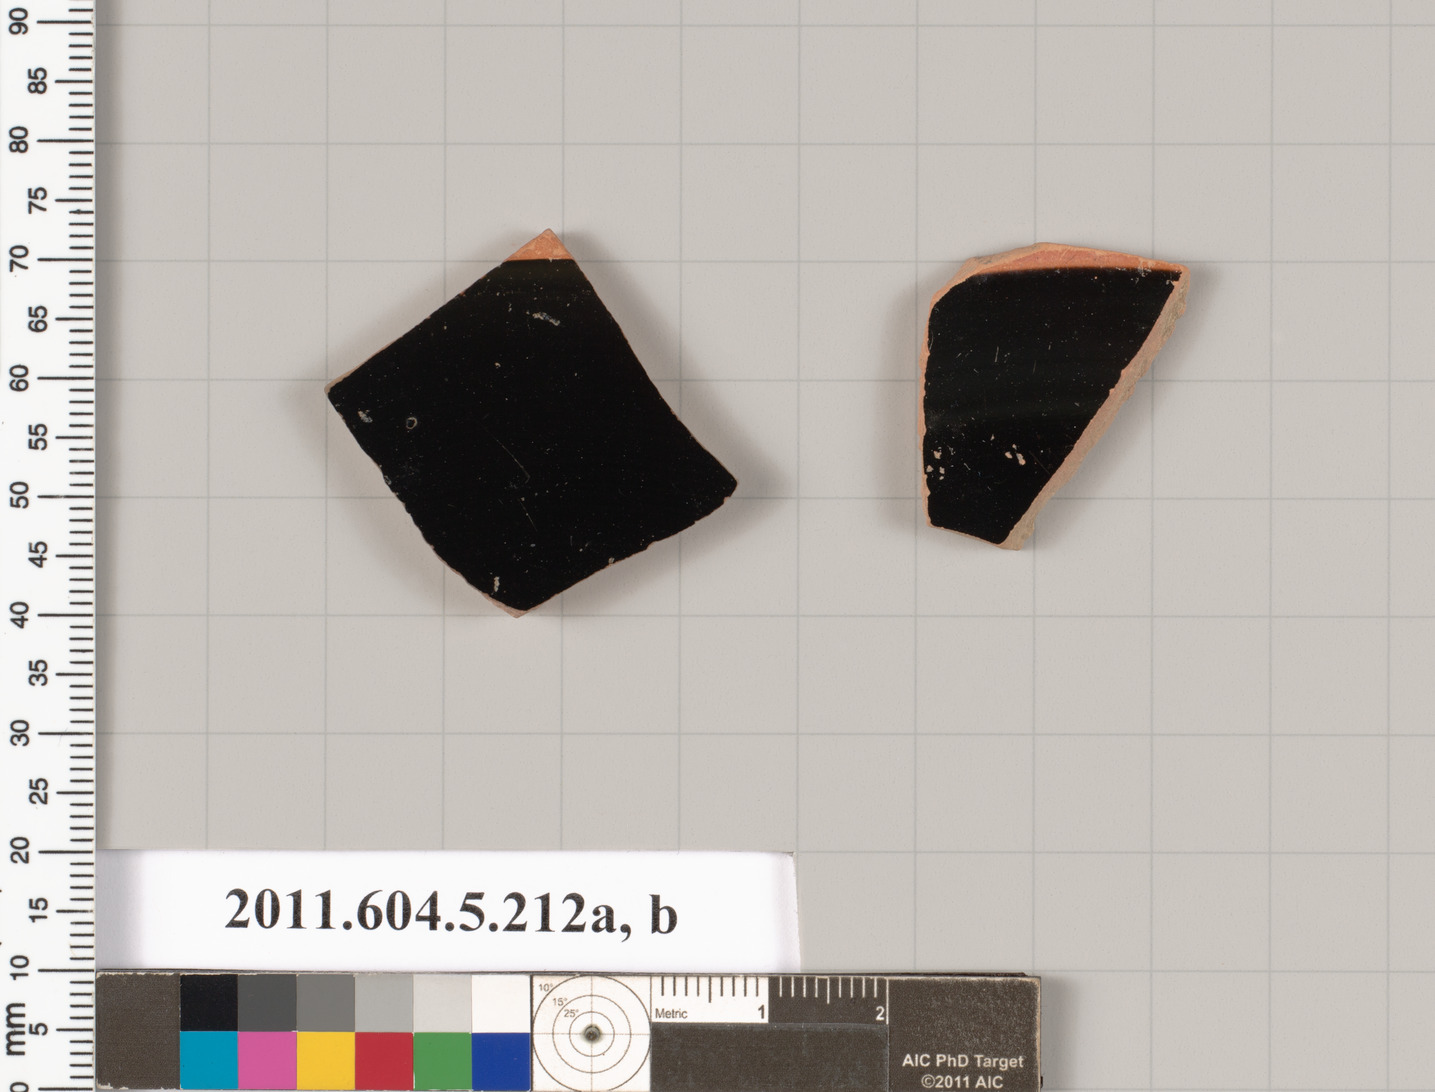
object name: kylix fragment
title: Terracotta fragments of kylikes (drinking cups)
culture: greek, attic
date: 600-401 BCE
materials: terracotta